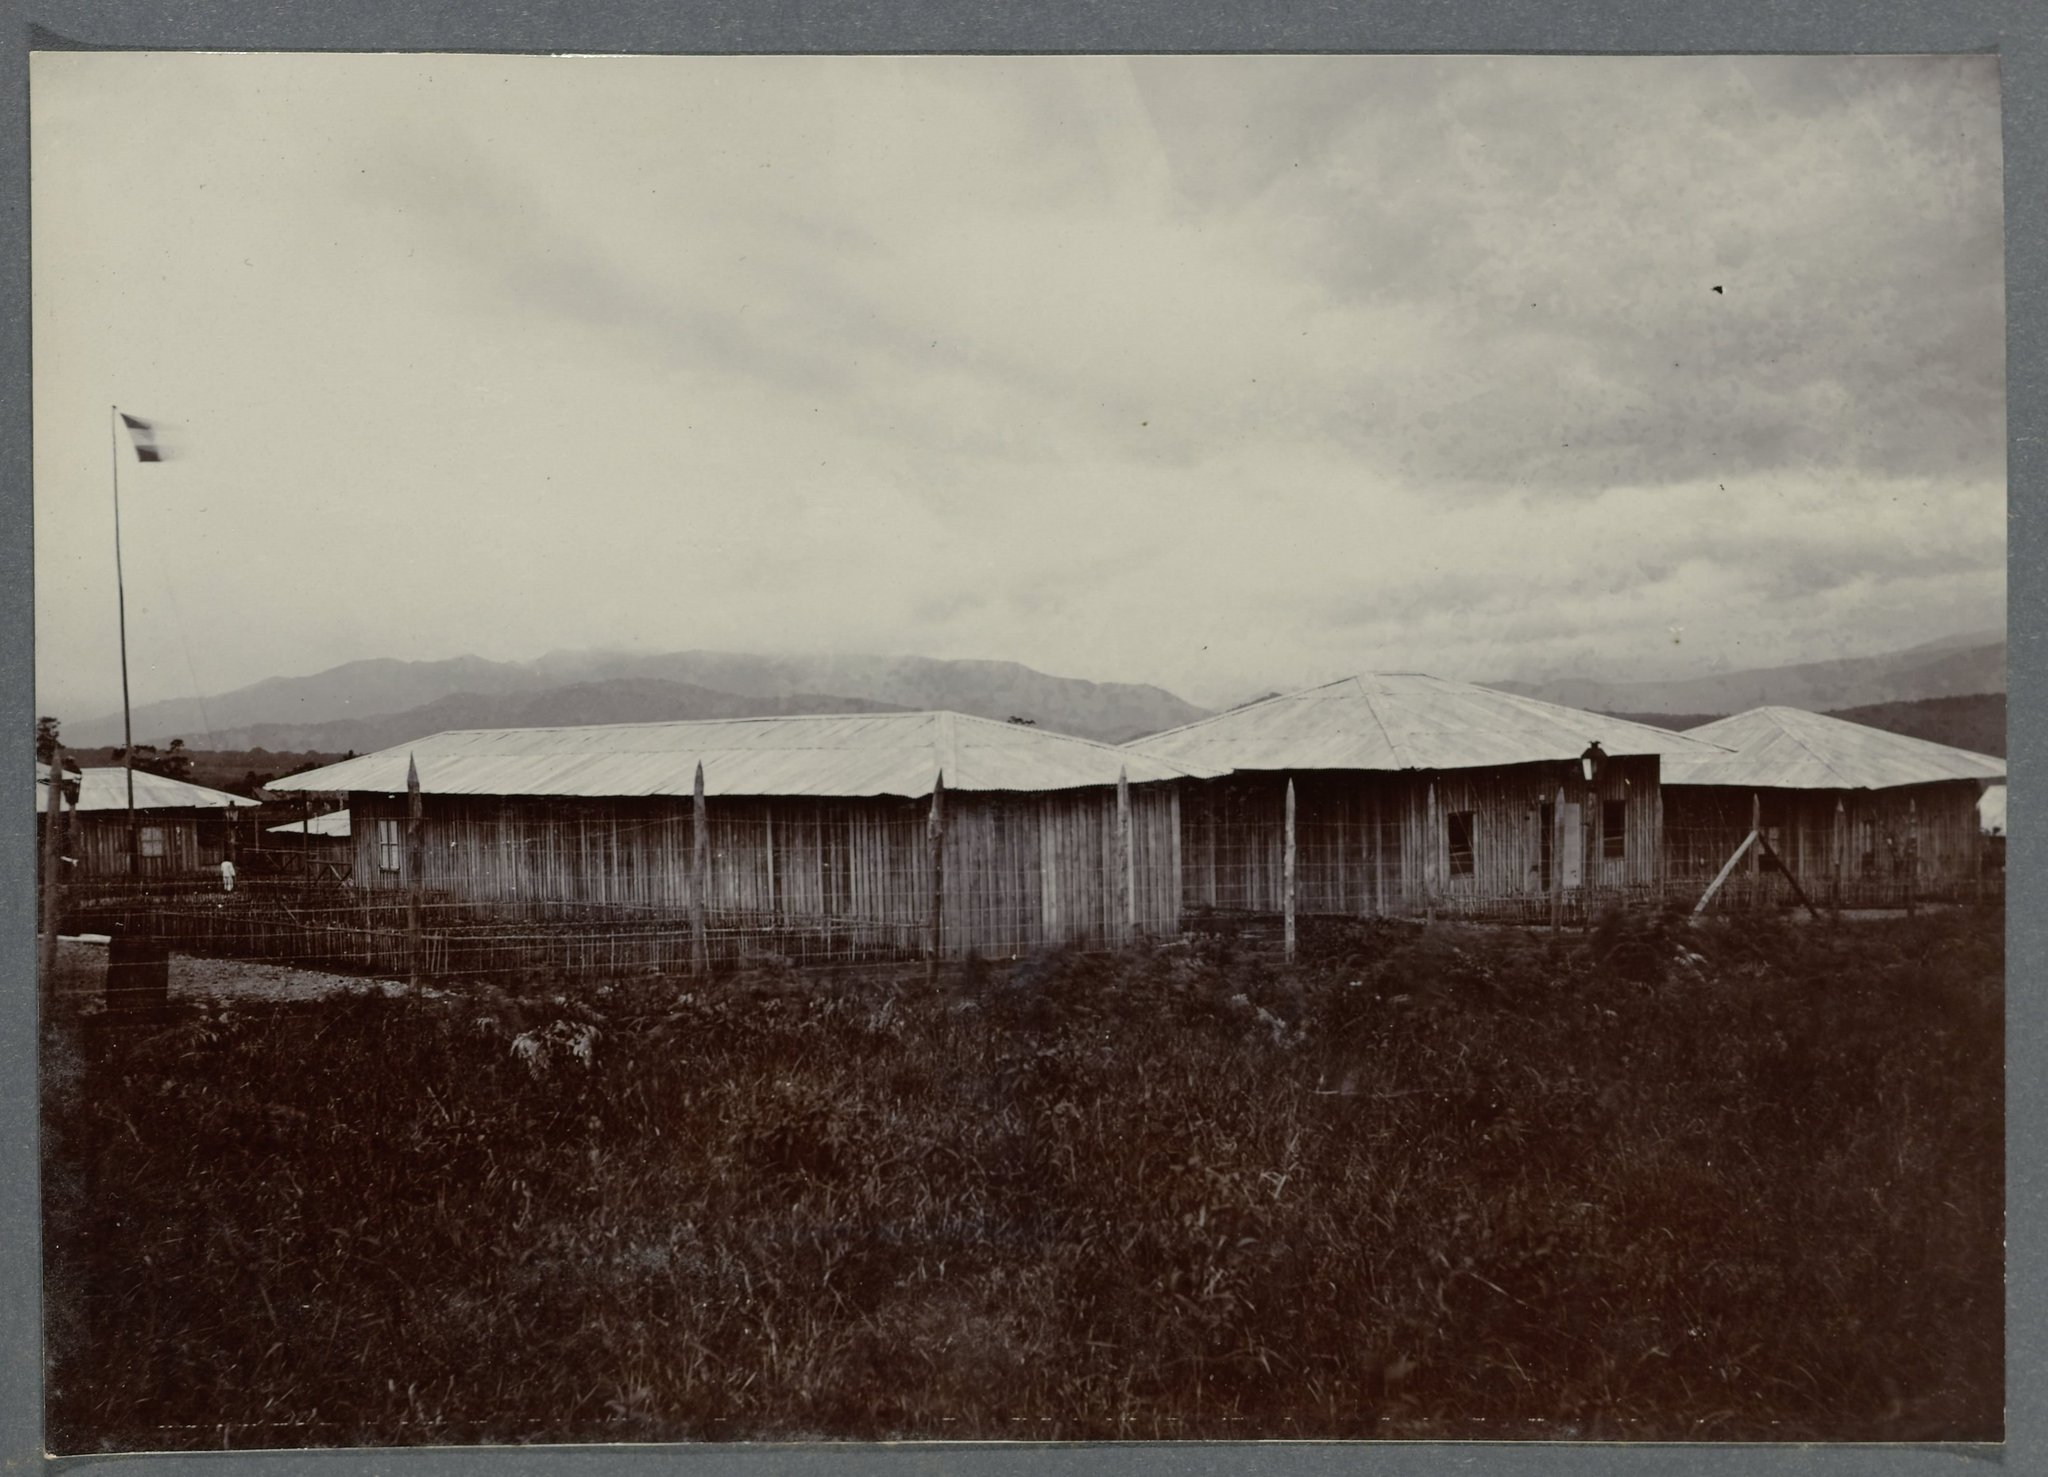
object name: photograph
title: Bivak op open vlakte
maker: Anonymous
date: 1903-1913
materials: photographic support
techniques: gelatin silver print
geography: north sumatra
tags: arnhem, albertus dominicus laman trip, building activities, traffic by road or path with motor-vehicle, landscapes in tropical and sub-tropical regions, road, path, hut, cabin, lodge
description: Na de expedities naar de Gajo- en Alaslanden o.l.v. Van Daalen (eerste tocht in 1901), werd hij in 1903 belast met voorbereiding van permanente vestiging van Nederlands gezag. Aanleg van een weg van de Noordkust naar het binnenland was hierbij van groot belang. Deze zgn. Gajoweg werd aangelegd tussen 1903 en 1914, van Bireuen aan de kust naar Takinguen aan het bergmeer Danau Lauttawar, totale lengte 104 km.